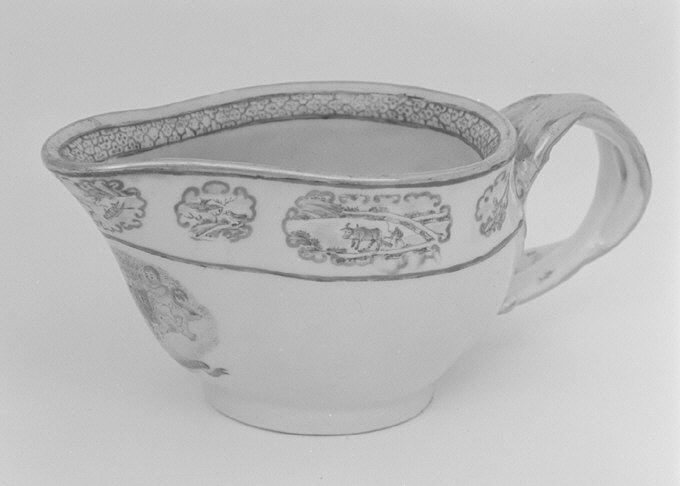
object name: gravy boat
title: Gravy boat (part of a service)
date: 1800-1805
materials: hard paste porcelain